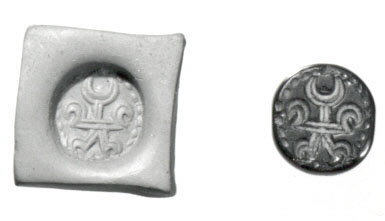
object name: stamp seal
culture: sasanian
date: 201-700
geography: iran or mesopotamia